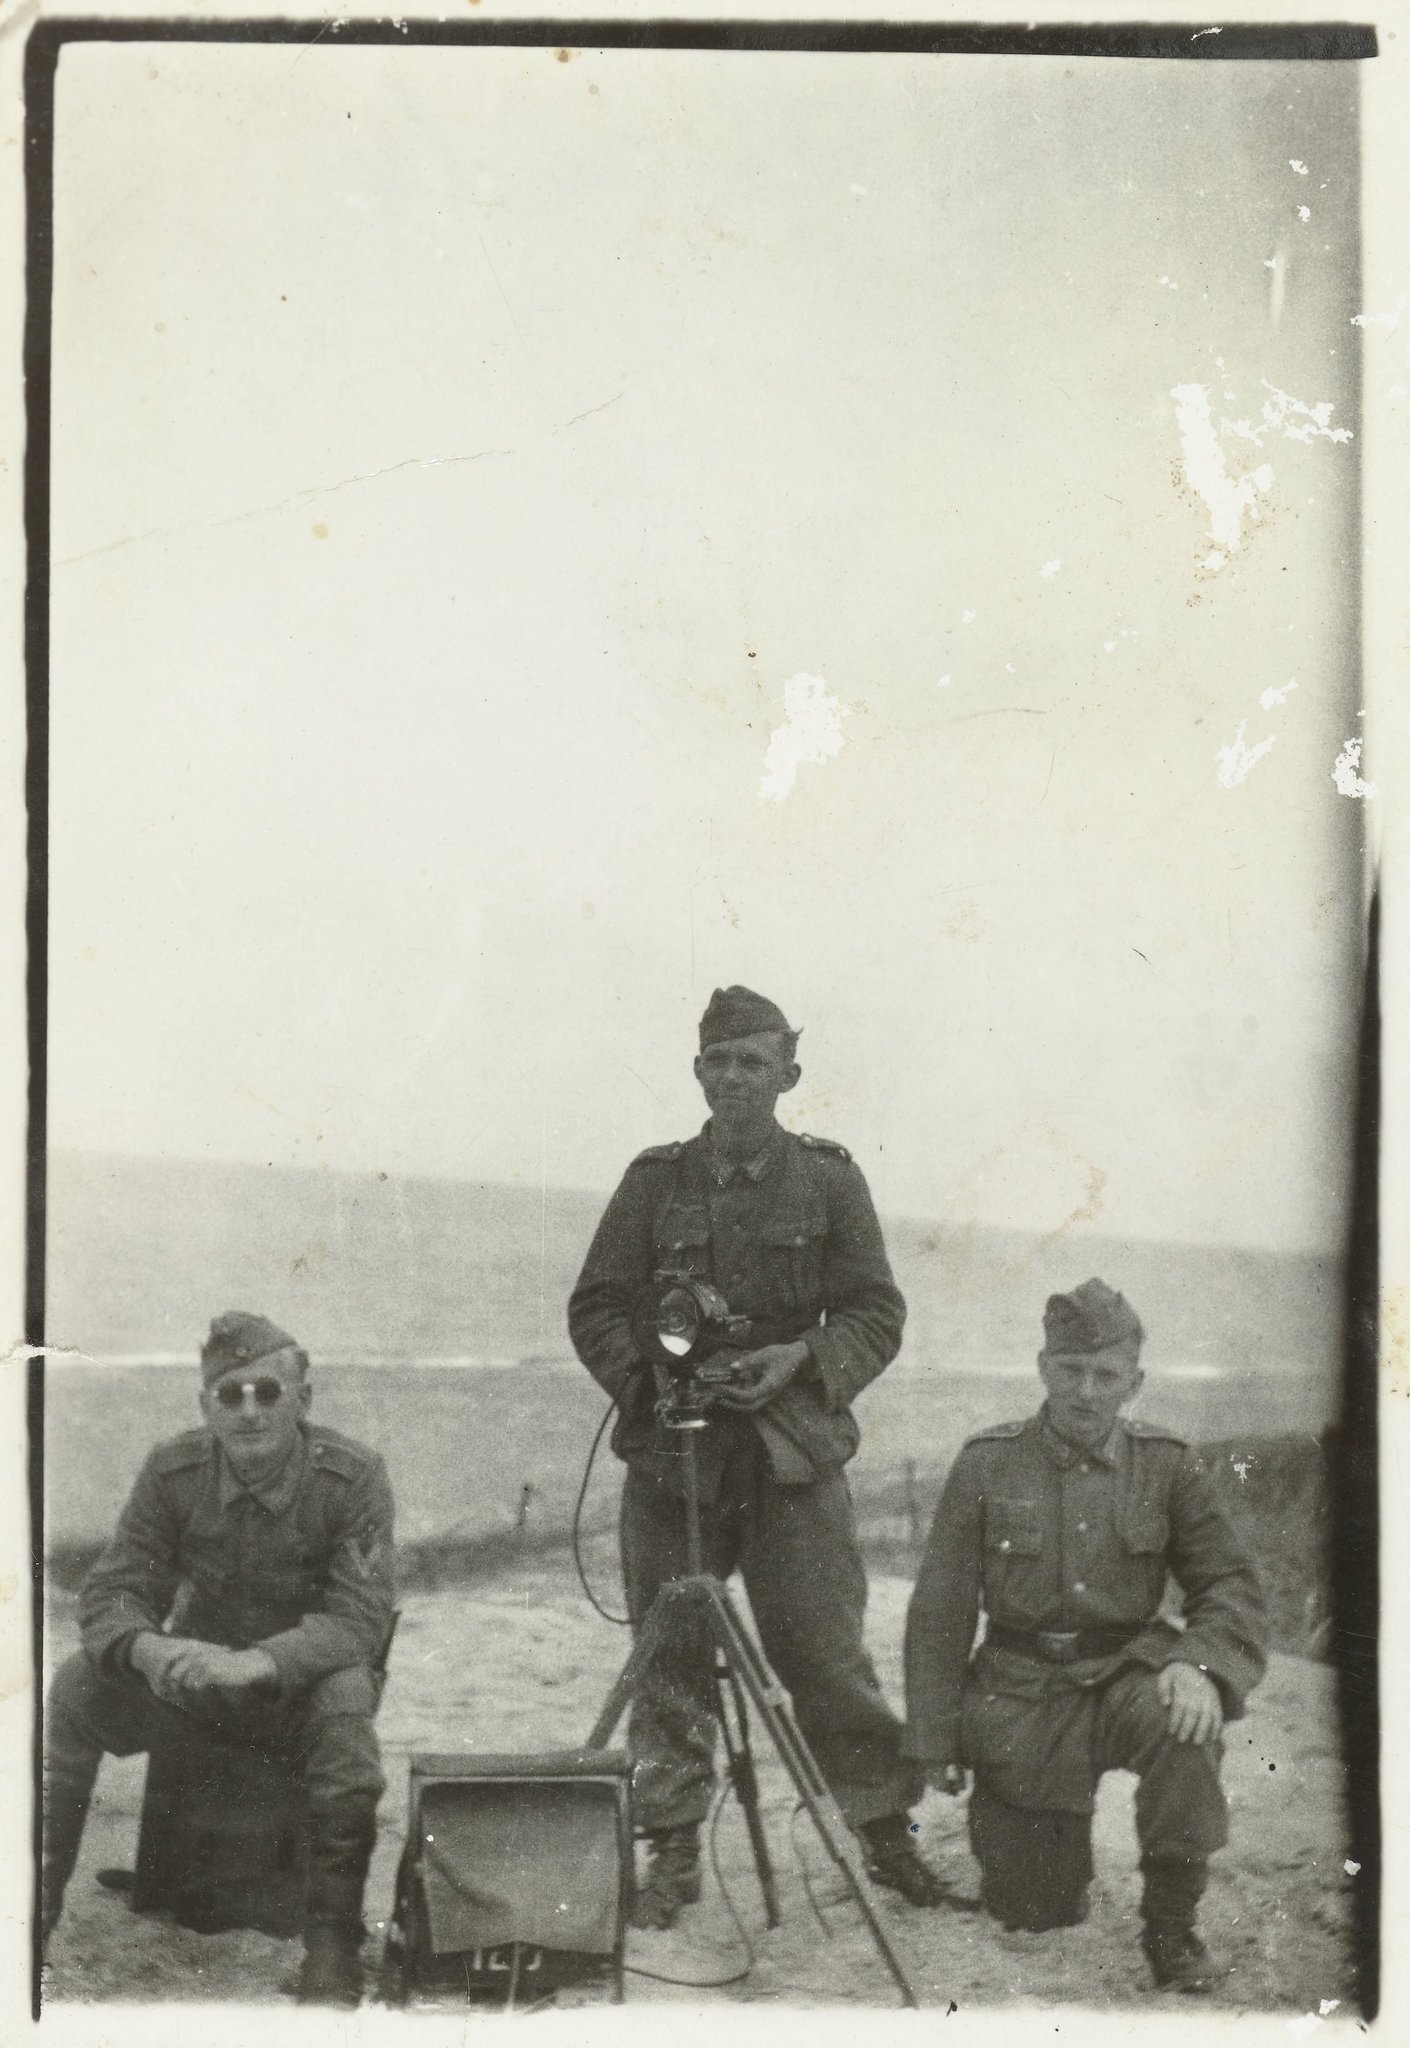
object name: photograph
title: Drie Wehrmachtsoldaten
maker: Anonymous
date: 1940-1945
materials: photographic support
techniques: gelatin silver print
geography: netherlands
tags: netherlands, germany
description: Drie Wehrmachtsoldaten, een zit, een staat achter een schijnwerper, de derde knielt. Opschrift: Am Strande bei der 'Blinck' Ausbildung. Foto behorend bij album 'Kriegserinnerungen'.